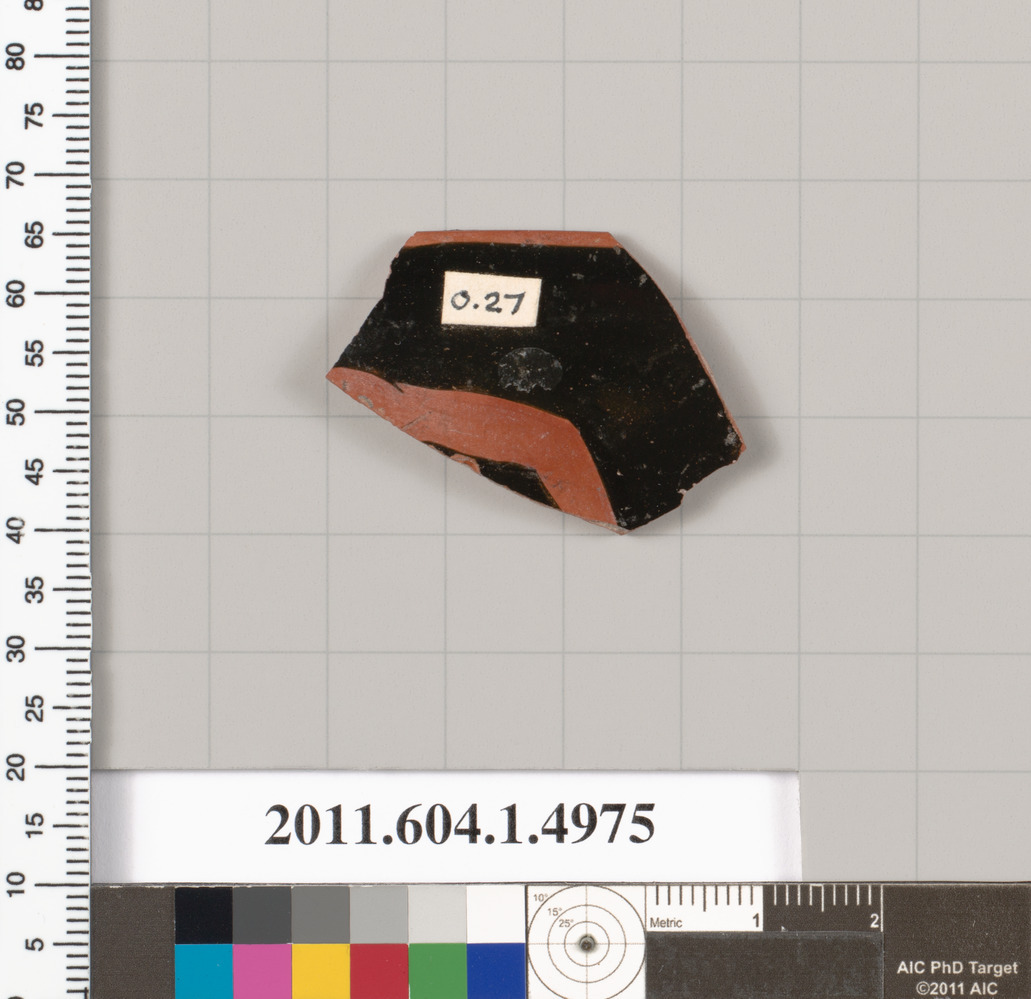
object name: kylix fragment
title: Terracotta rim fragment of a kylix (drinking cup)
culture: greek, attic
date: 500-480 BCE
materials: terracotta